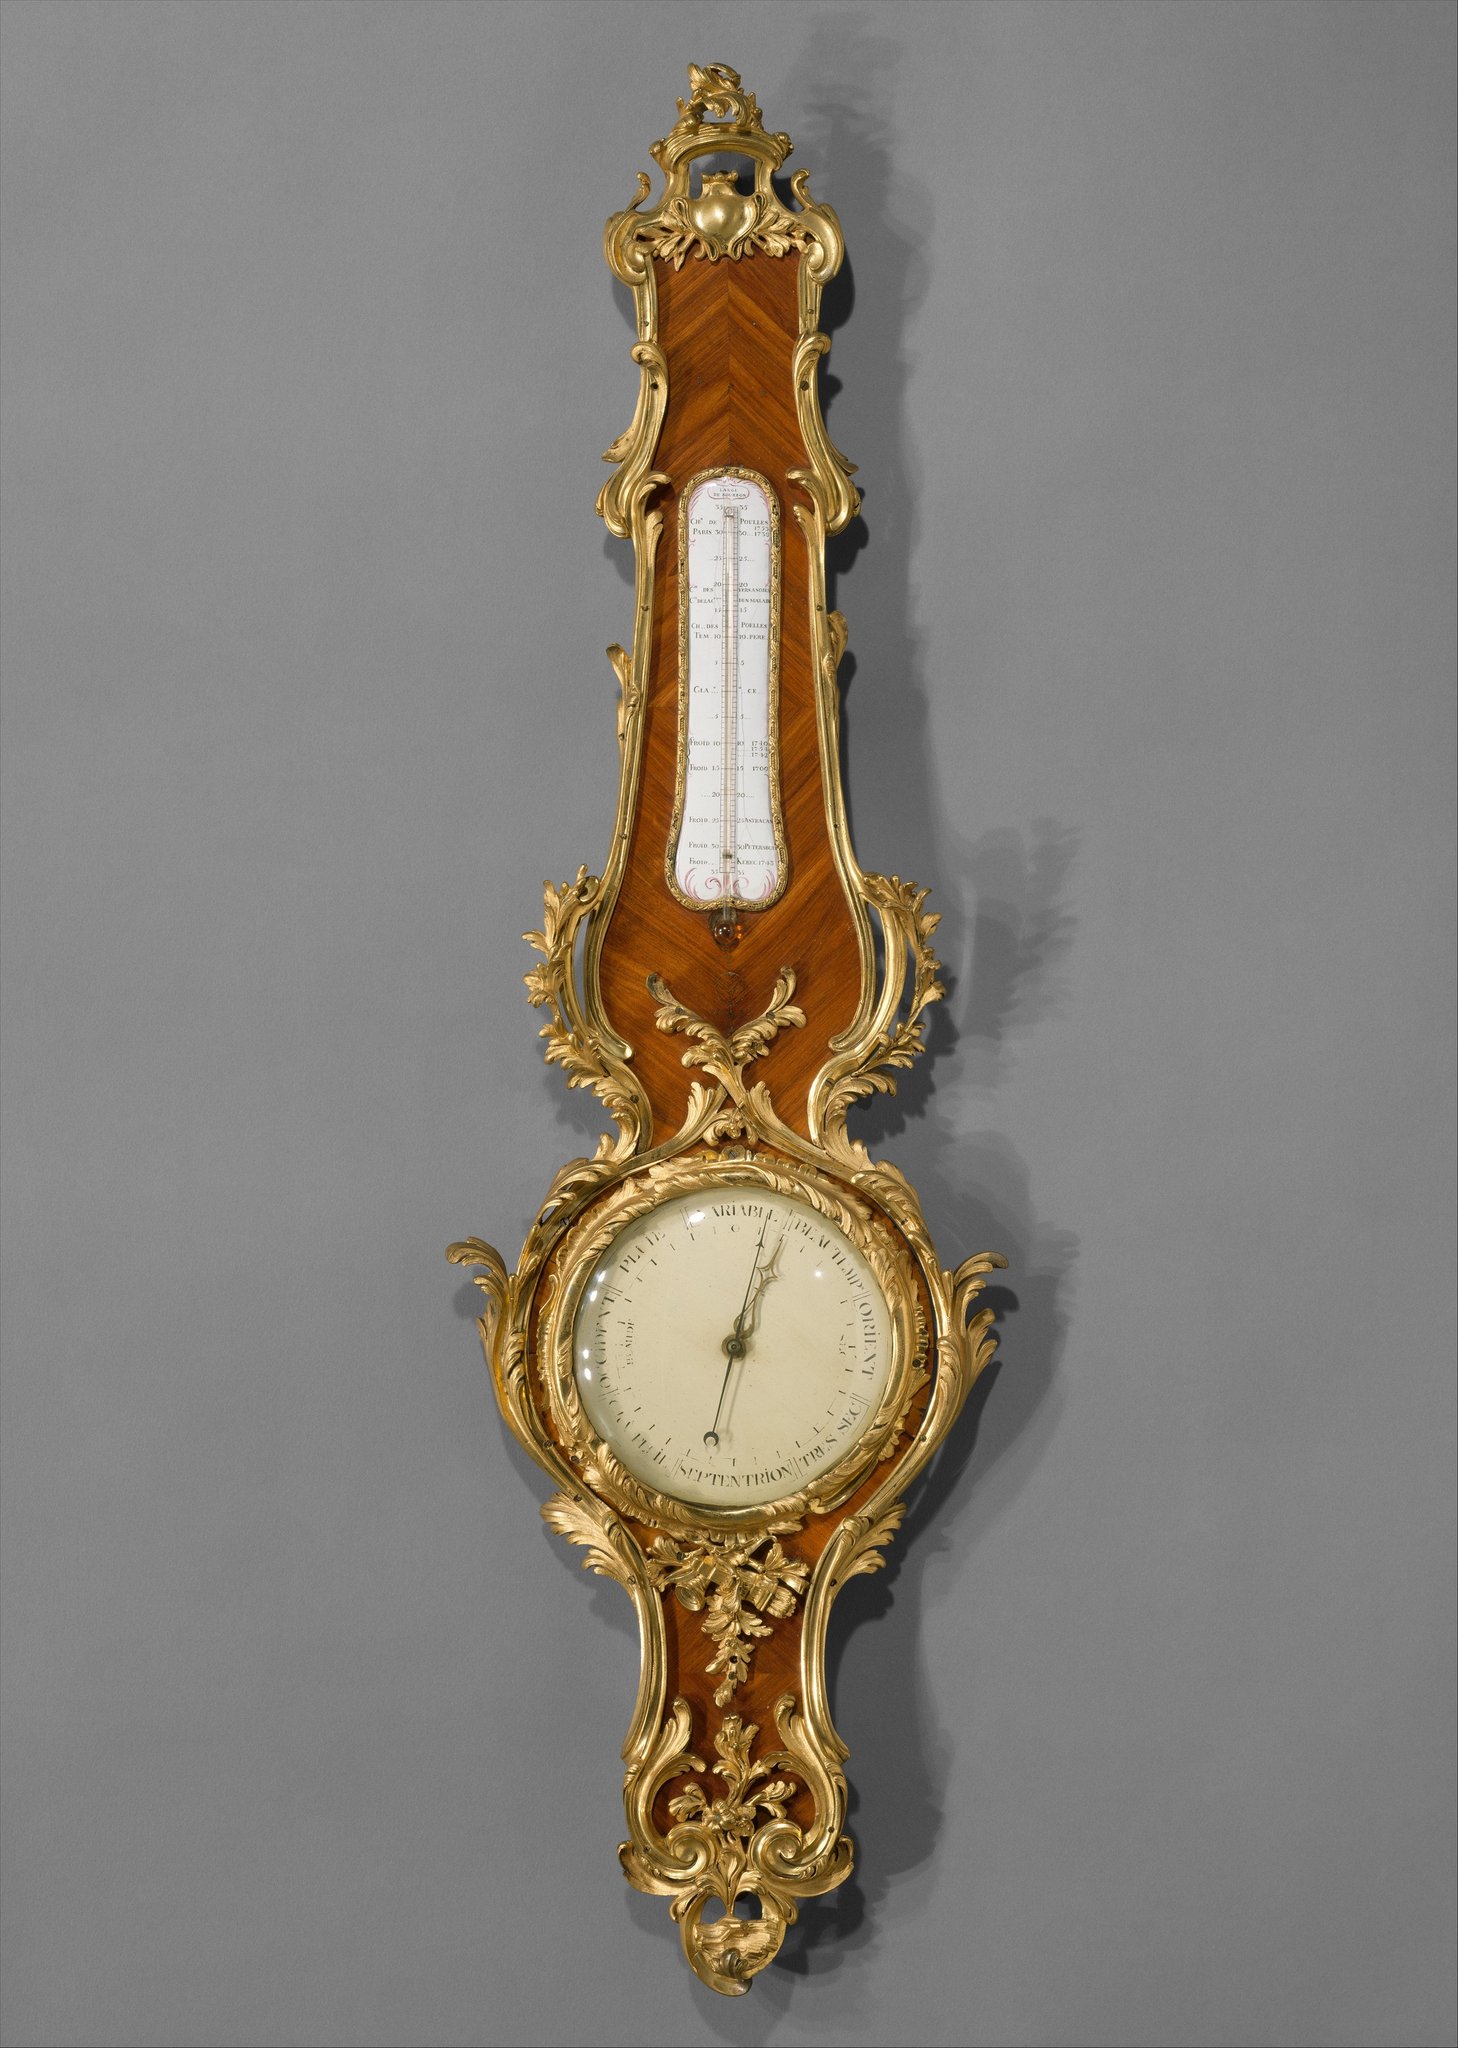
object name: wall barometer thermometer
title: Wall barometer-thermometer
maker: lange de bourbon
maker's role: maker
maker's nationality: french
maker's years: 1750-1775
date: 1760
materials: gilt bronze, wood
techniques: veneering